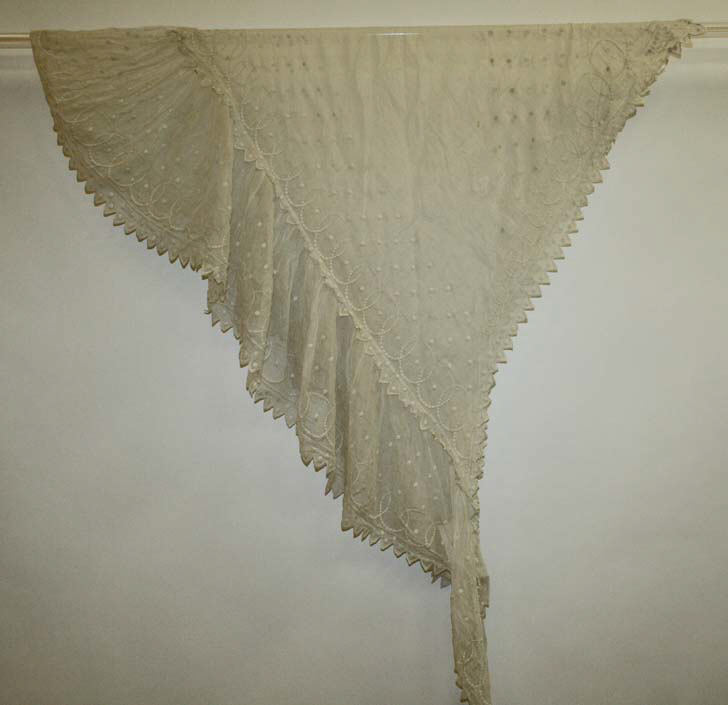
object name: fichu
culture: european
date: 1825-1839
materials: cotton